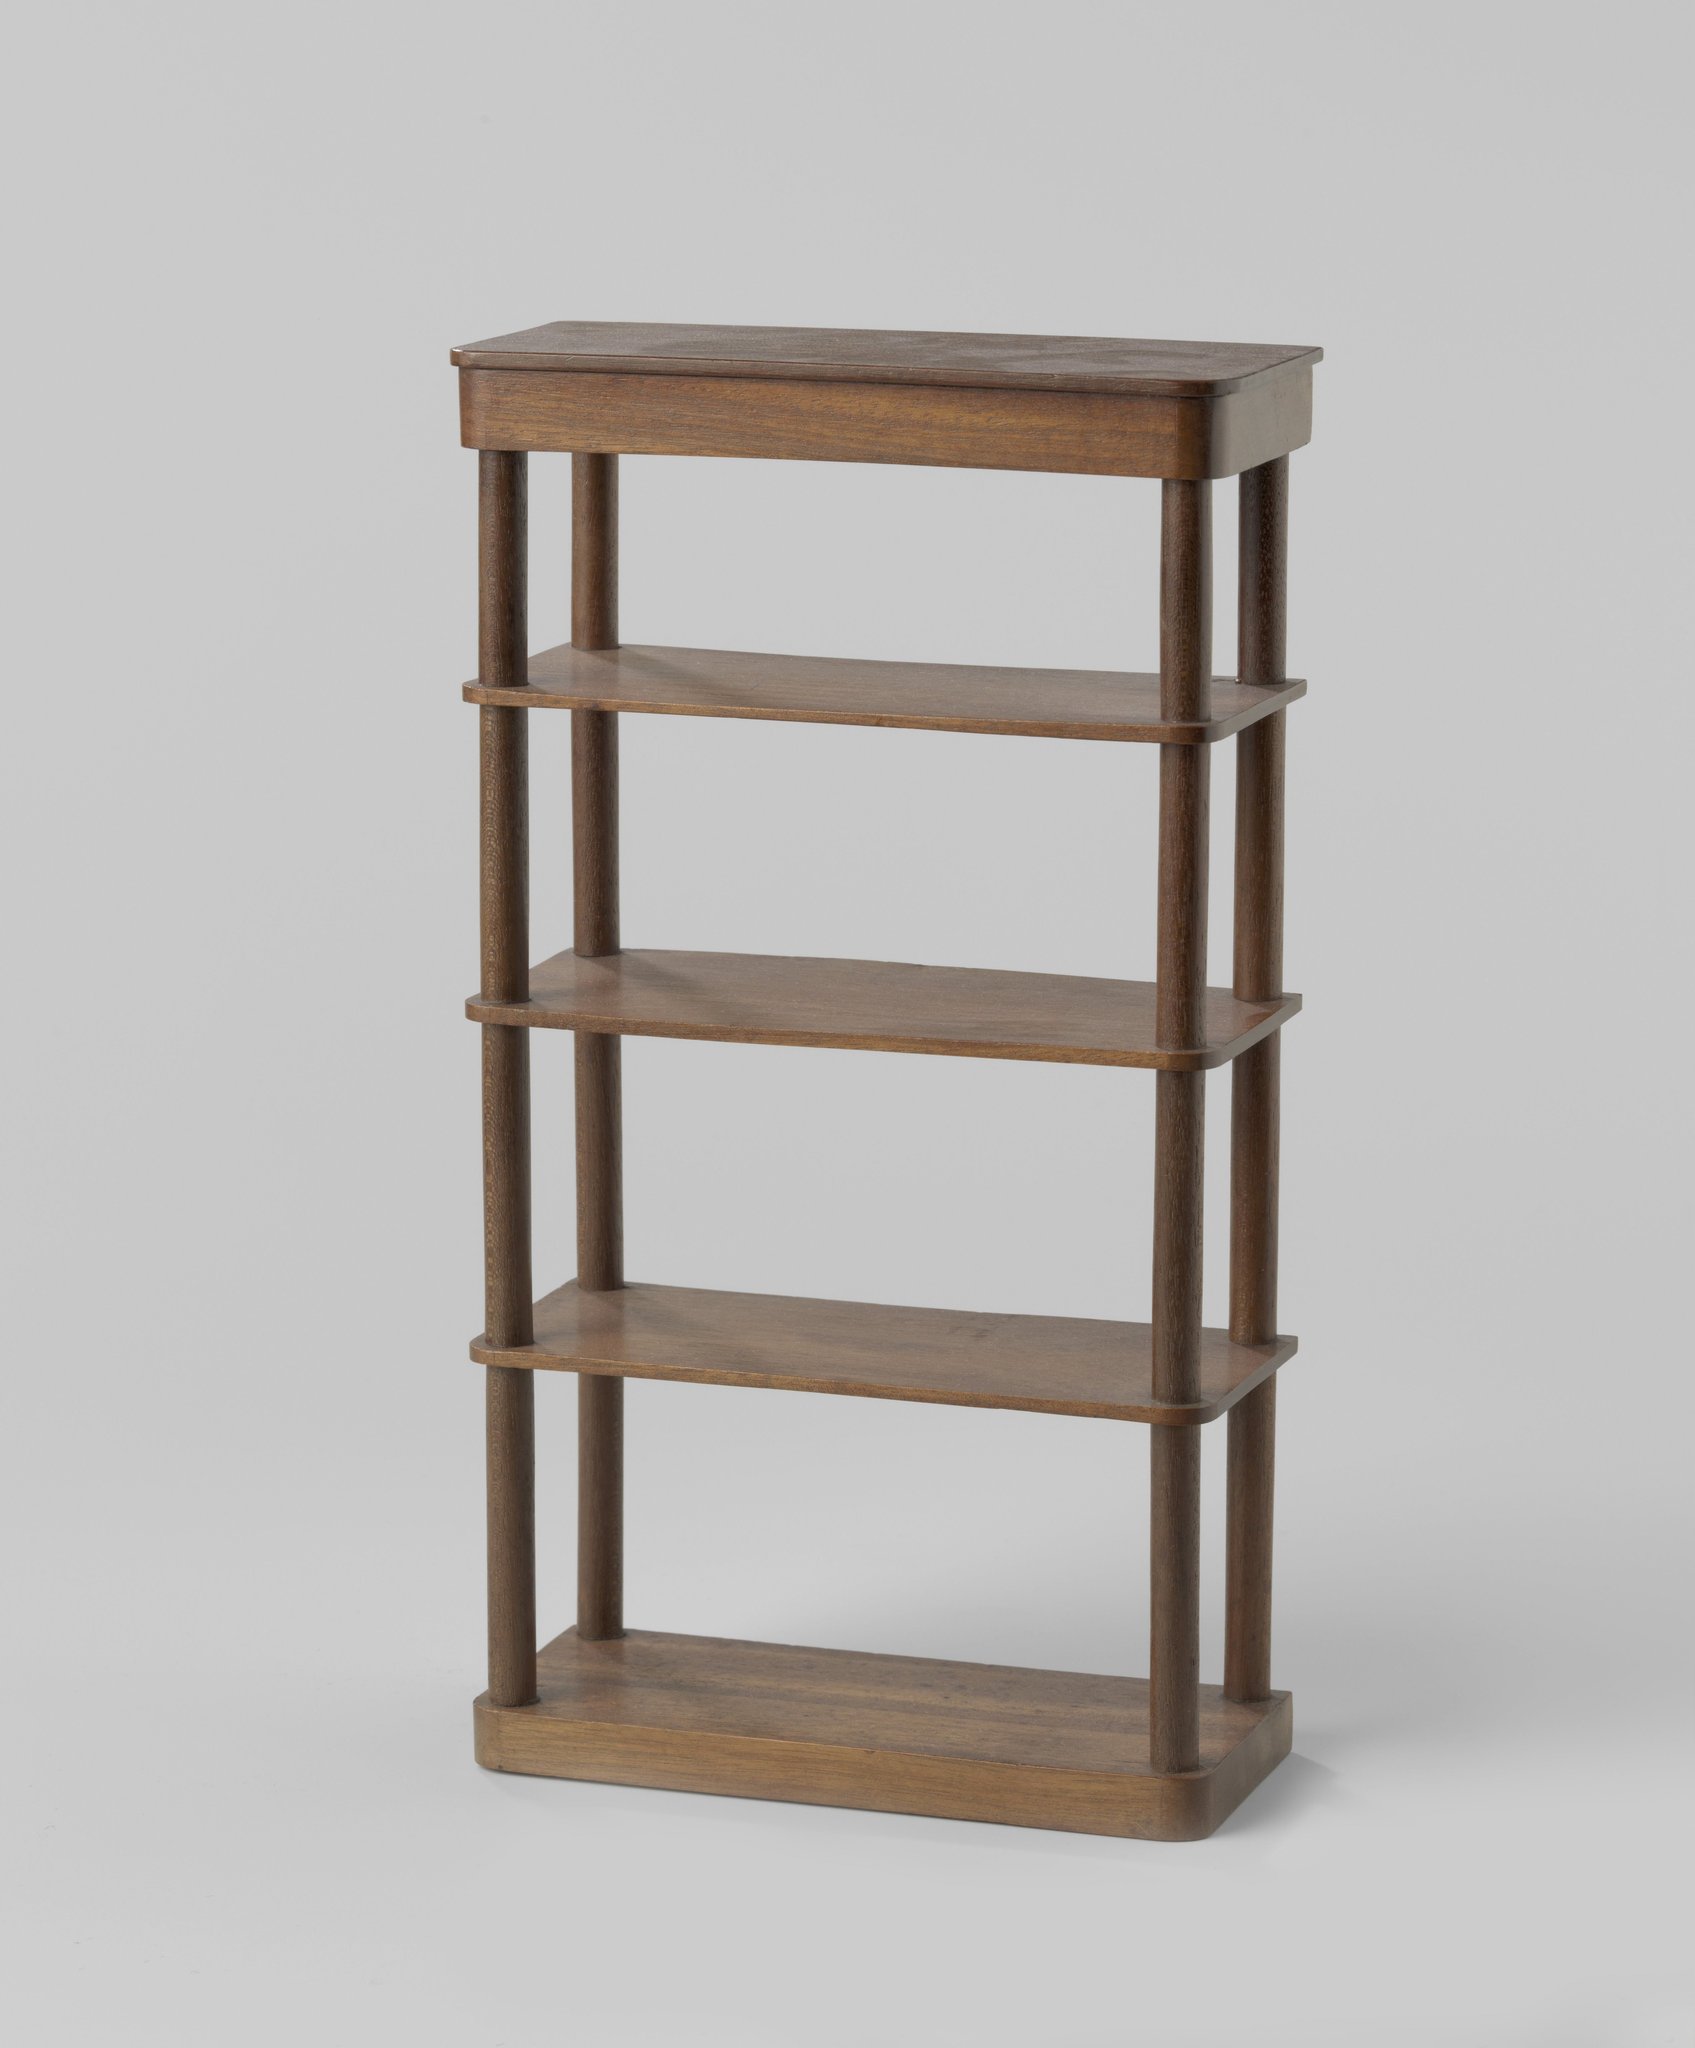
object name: stellingkast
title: Stellingkast met drie planken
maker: Anonymous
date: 1820-1840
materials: wood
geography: amsterdam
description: Stellingkast van mahoniehout, bestaande uit zware massieve plint, drie dunne planken en een massieve kap met dekplaat, onderling verbonden door ronde gladde stijlen.